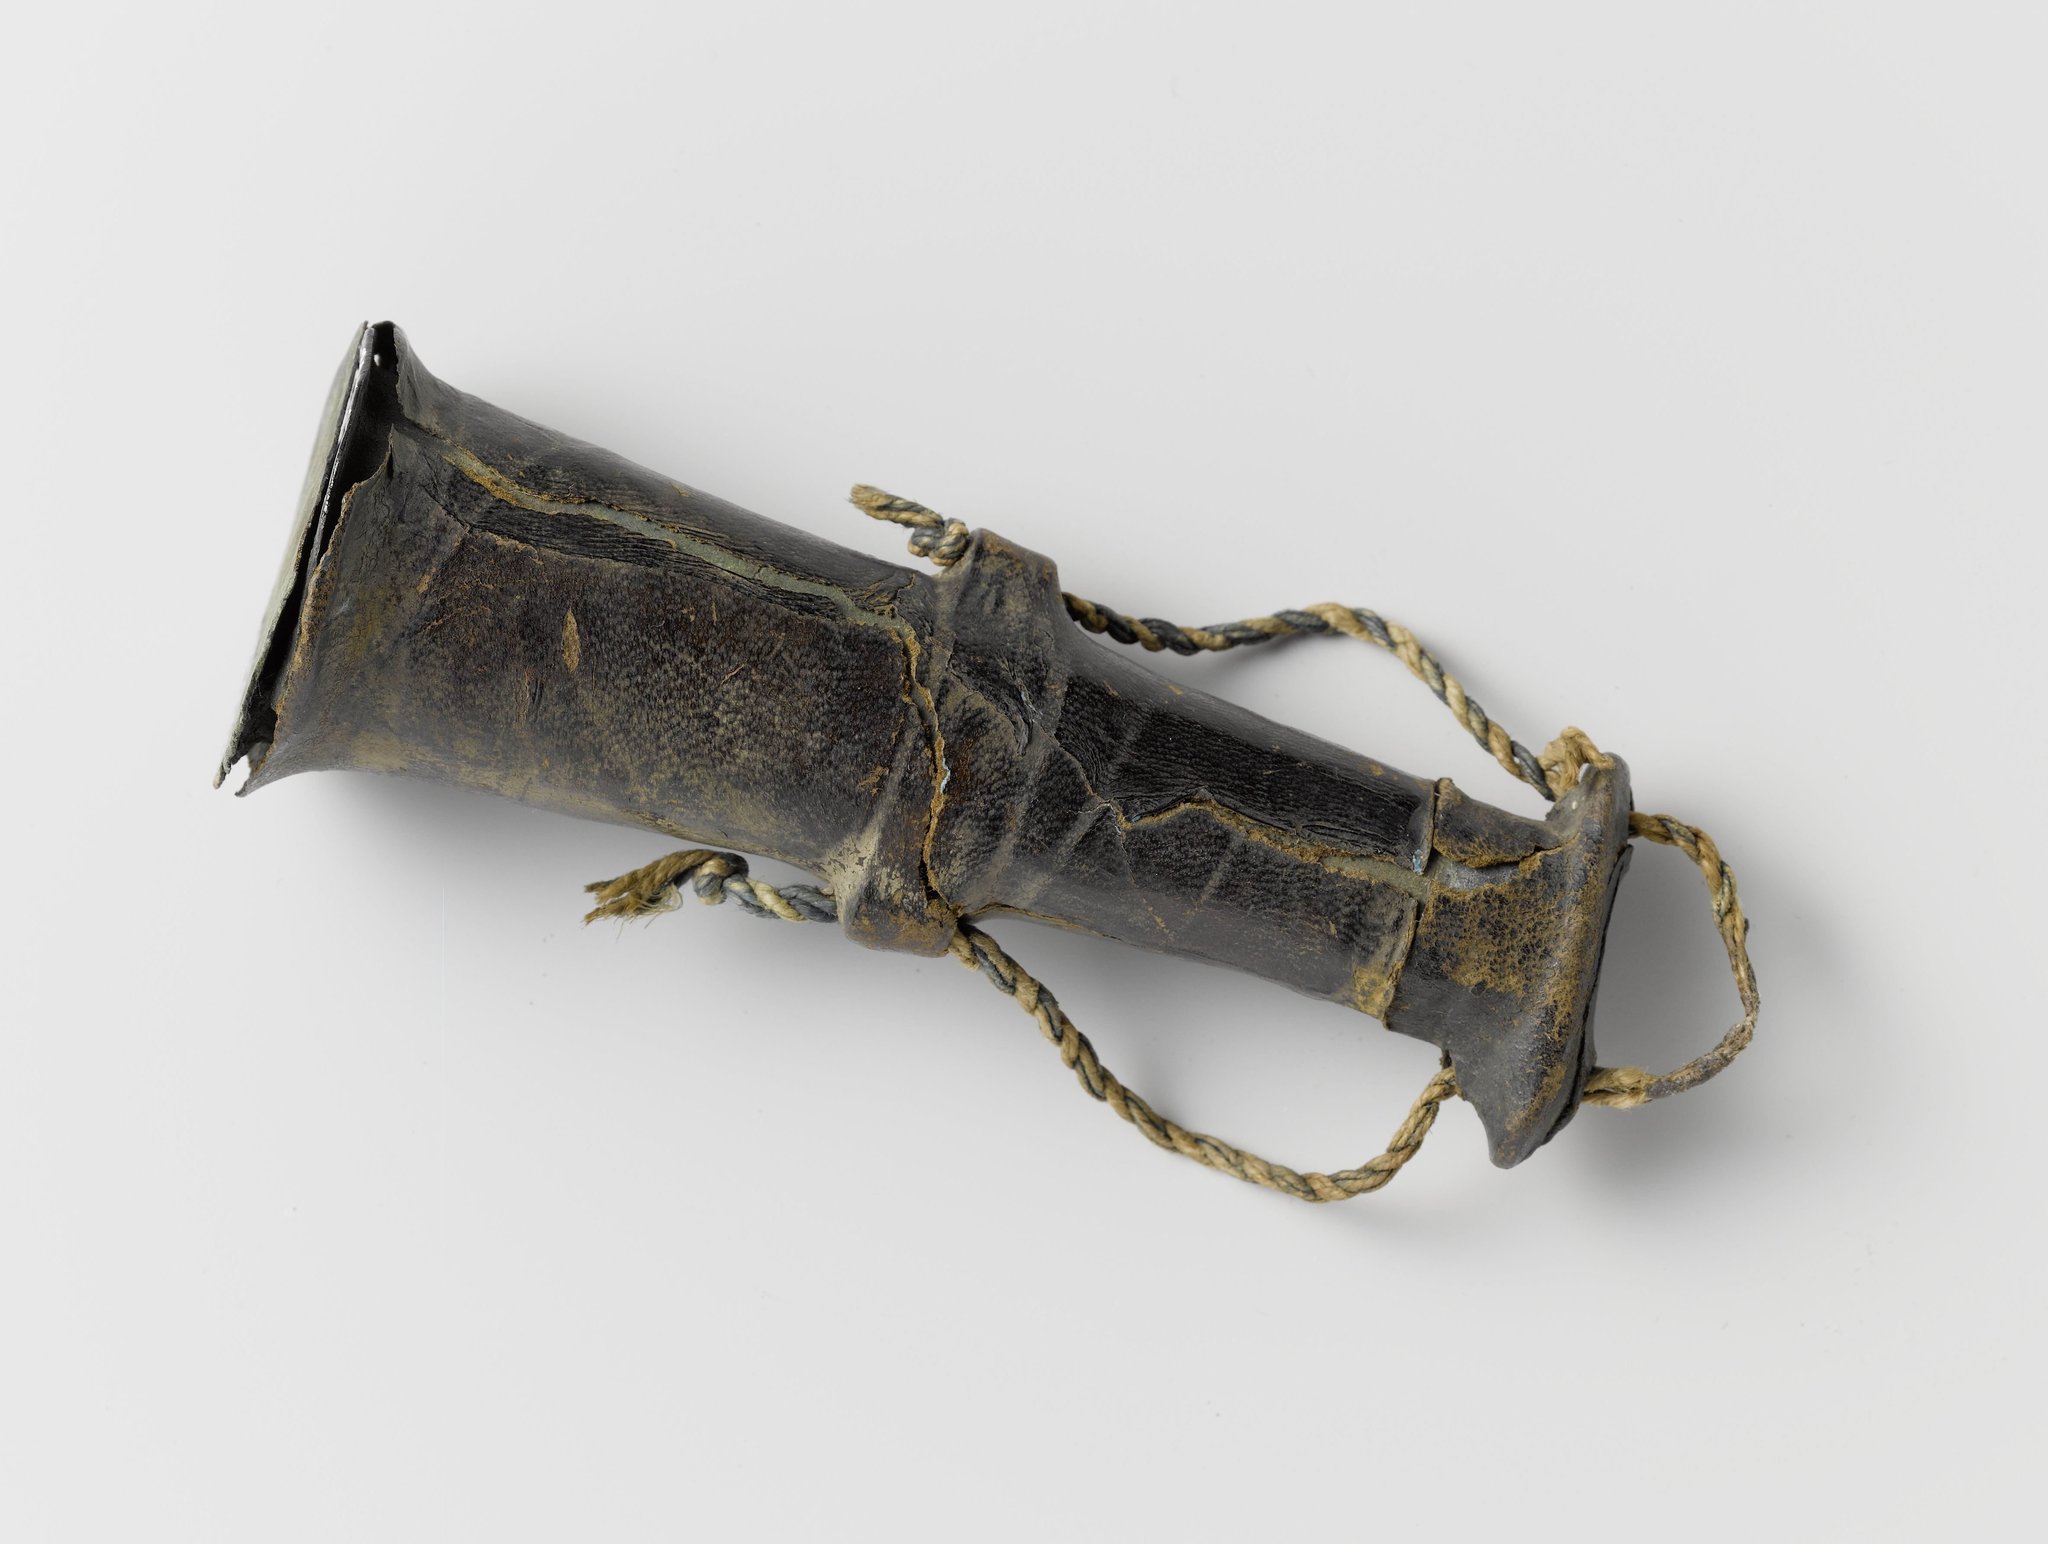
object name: kruitmaat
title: Musketmaat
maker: Anonymous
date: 1590-1596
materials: brass, leather, fiber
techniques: soldering, striking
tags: willem barendsz., amsterdam, jacob van heemskerck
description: Musket cartridges. A musket cartridge contained a precise measure of powder and allowed the musket to be fired at speed.